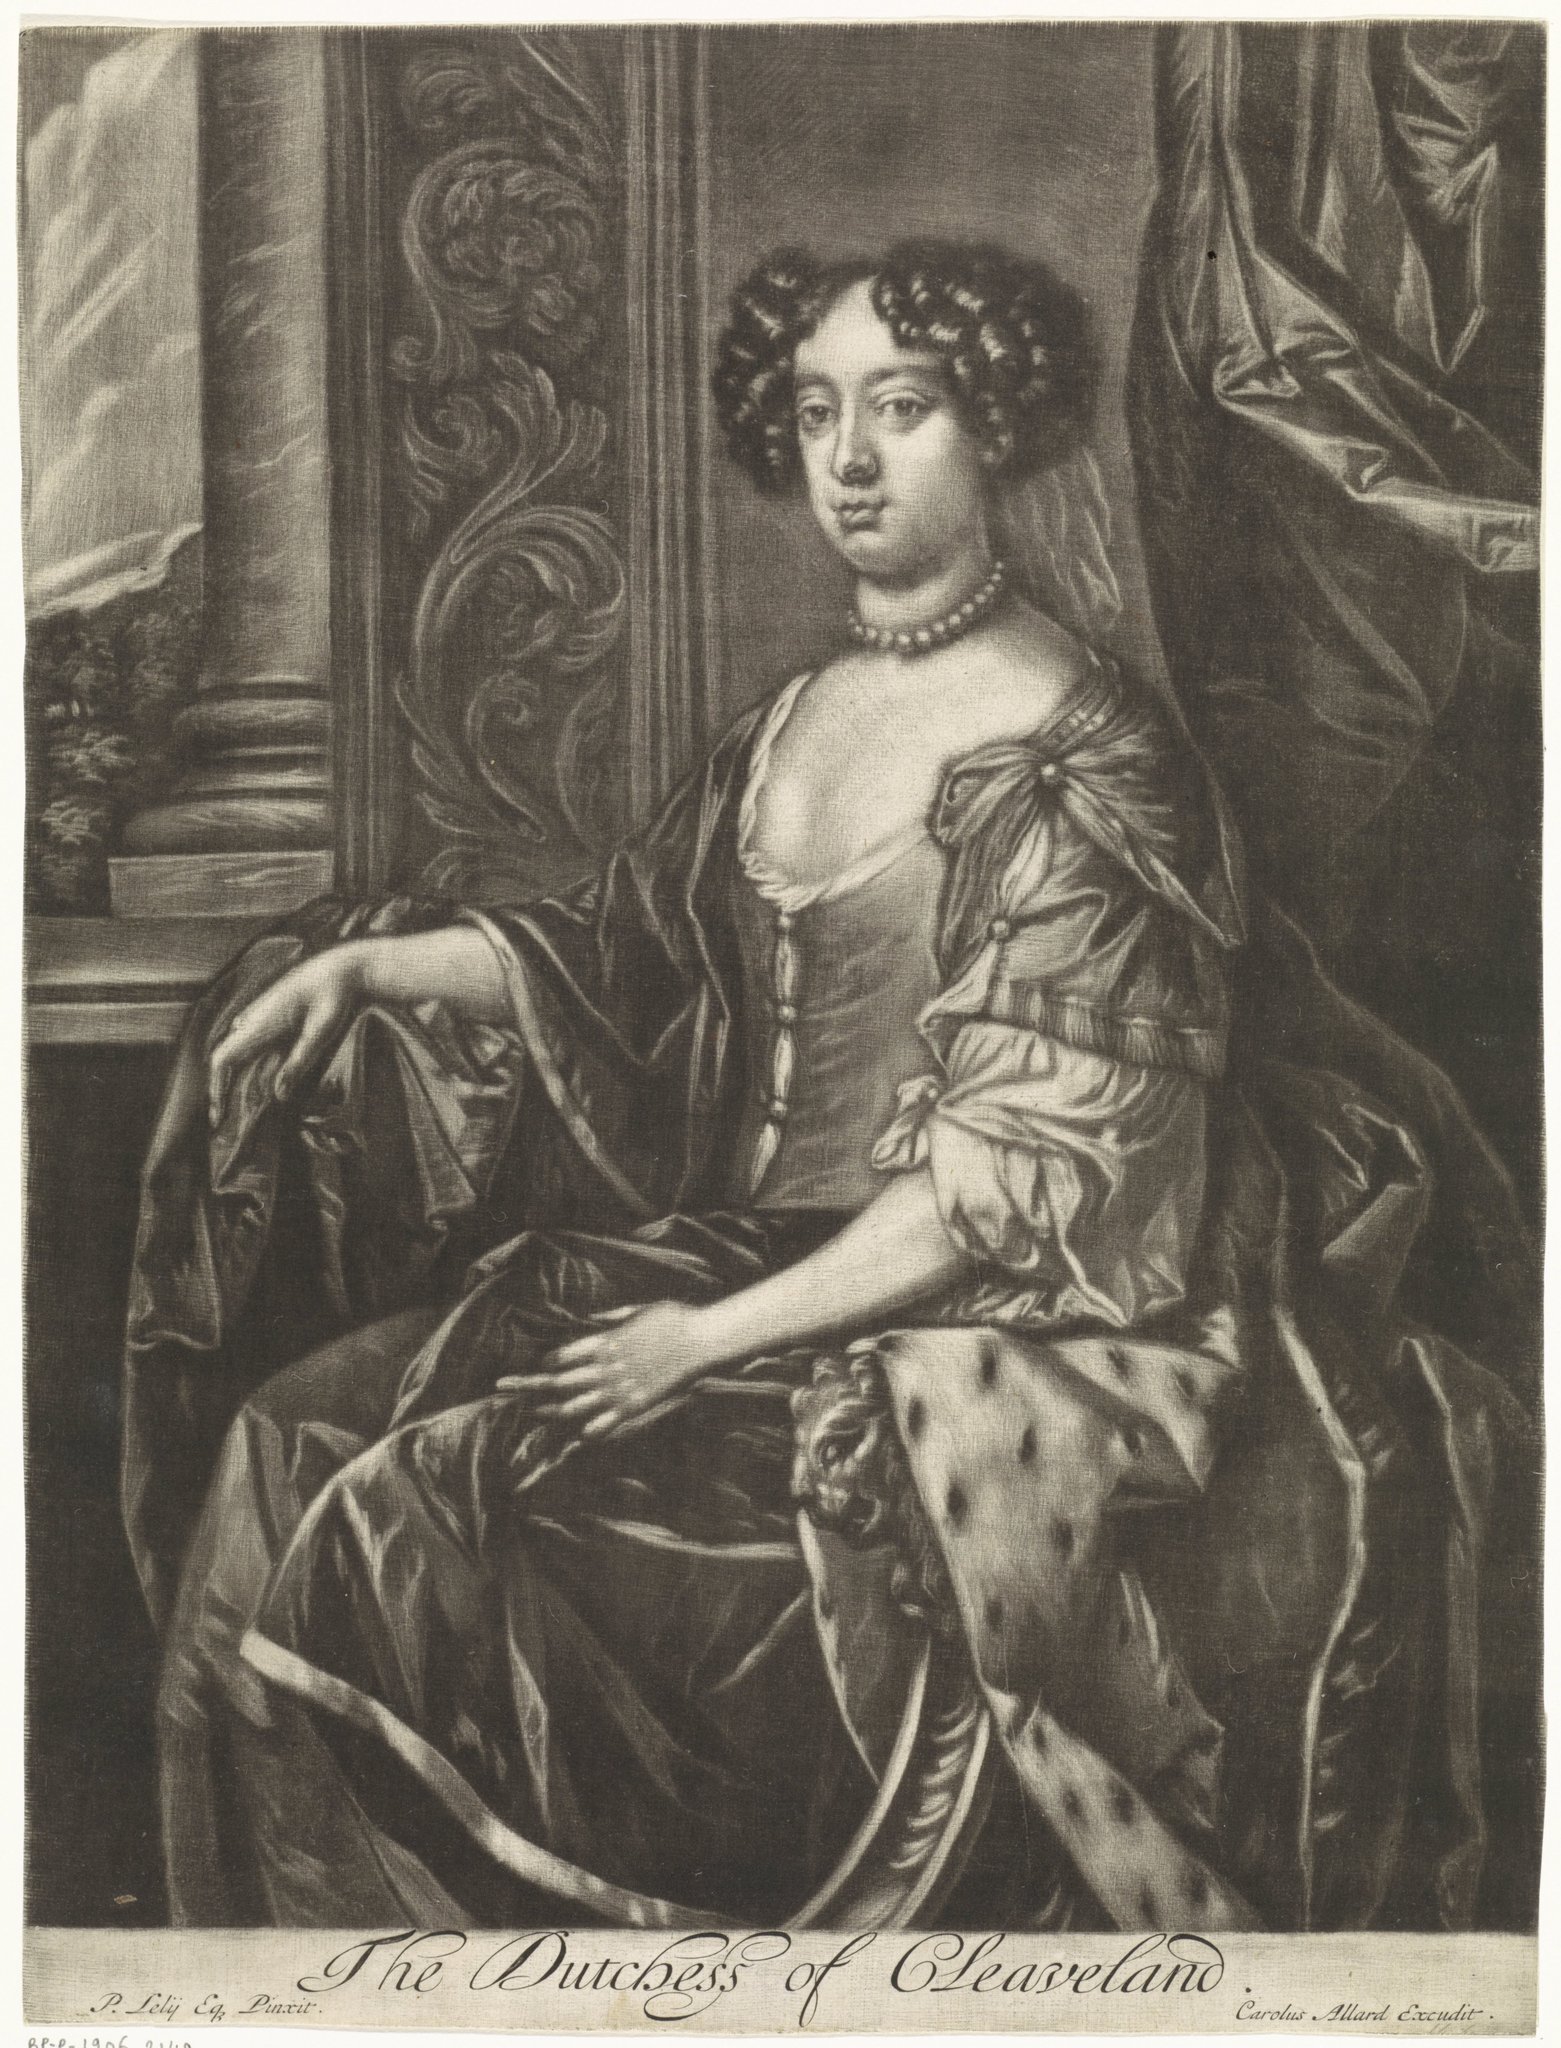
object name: print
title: Portret van Barbara Villiers hertogin van Cleveland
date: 1658-1706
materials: paper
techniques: engraving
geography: amsterdam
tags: london, pearl; pearl necklace (+ women's clothes)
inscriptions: collector's mark: Lugt 2228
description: Portret van Barbara Villiers, hertogin van Cleveland en één van de maîtresses van koning Karel II van Engeland. Ze zit bij een venster en draagt een parelketting.